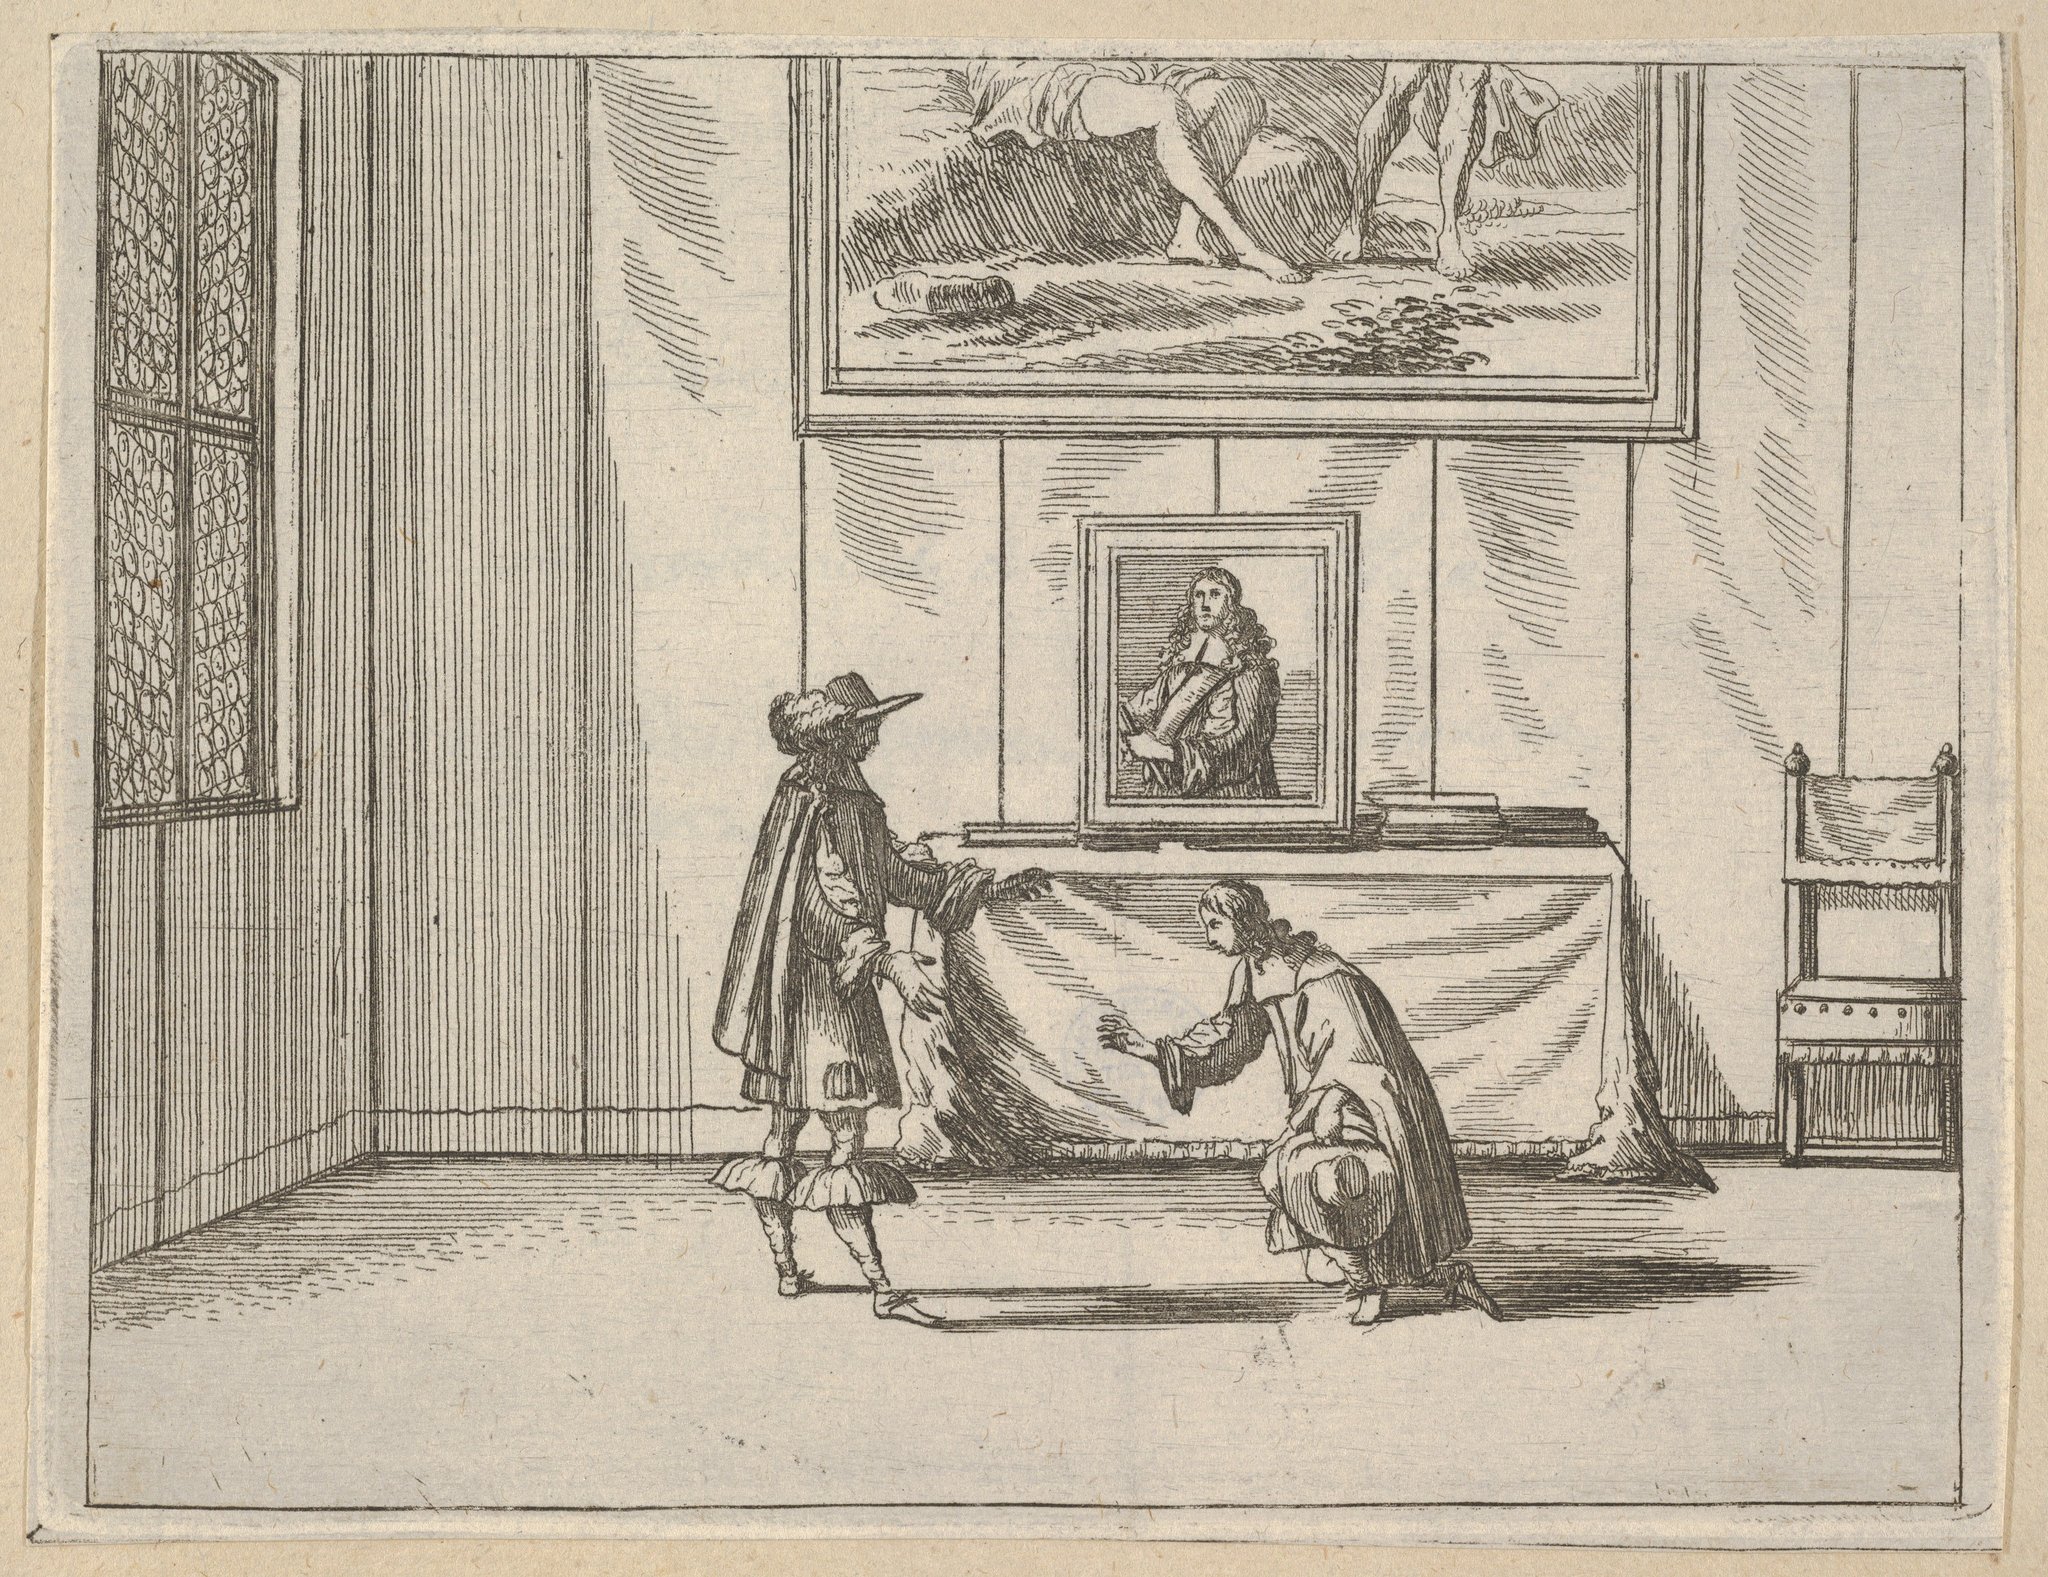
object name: print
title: Francesco I d'Este is Generous in Pardoning the Offenders, from "L'Idea di un Principe ed Eroe Cristiano in Francesco I d'Este, di Modena e Reggio Duca VIII [...]"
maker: bartolomeo fenice (fénis)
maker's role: artist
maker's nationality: italian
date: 1659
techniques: etching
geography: italy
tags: men,furniture